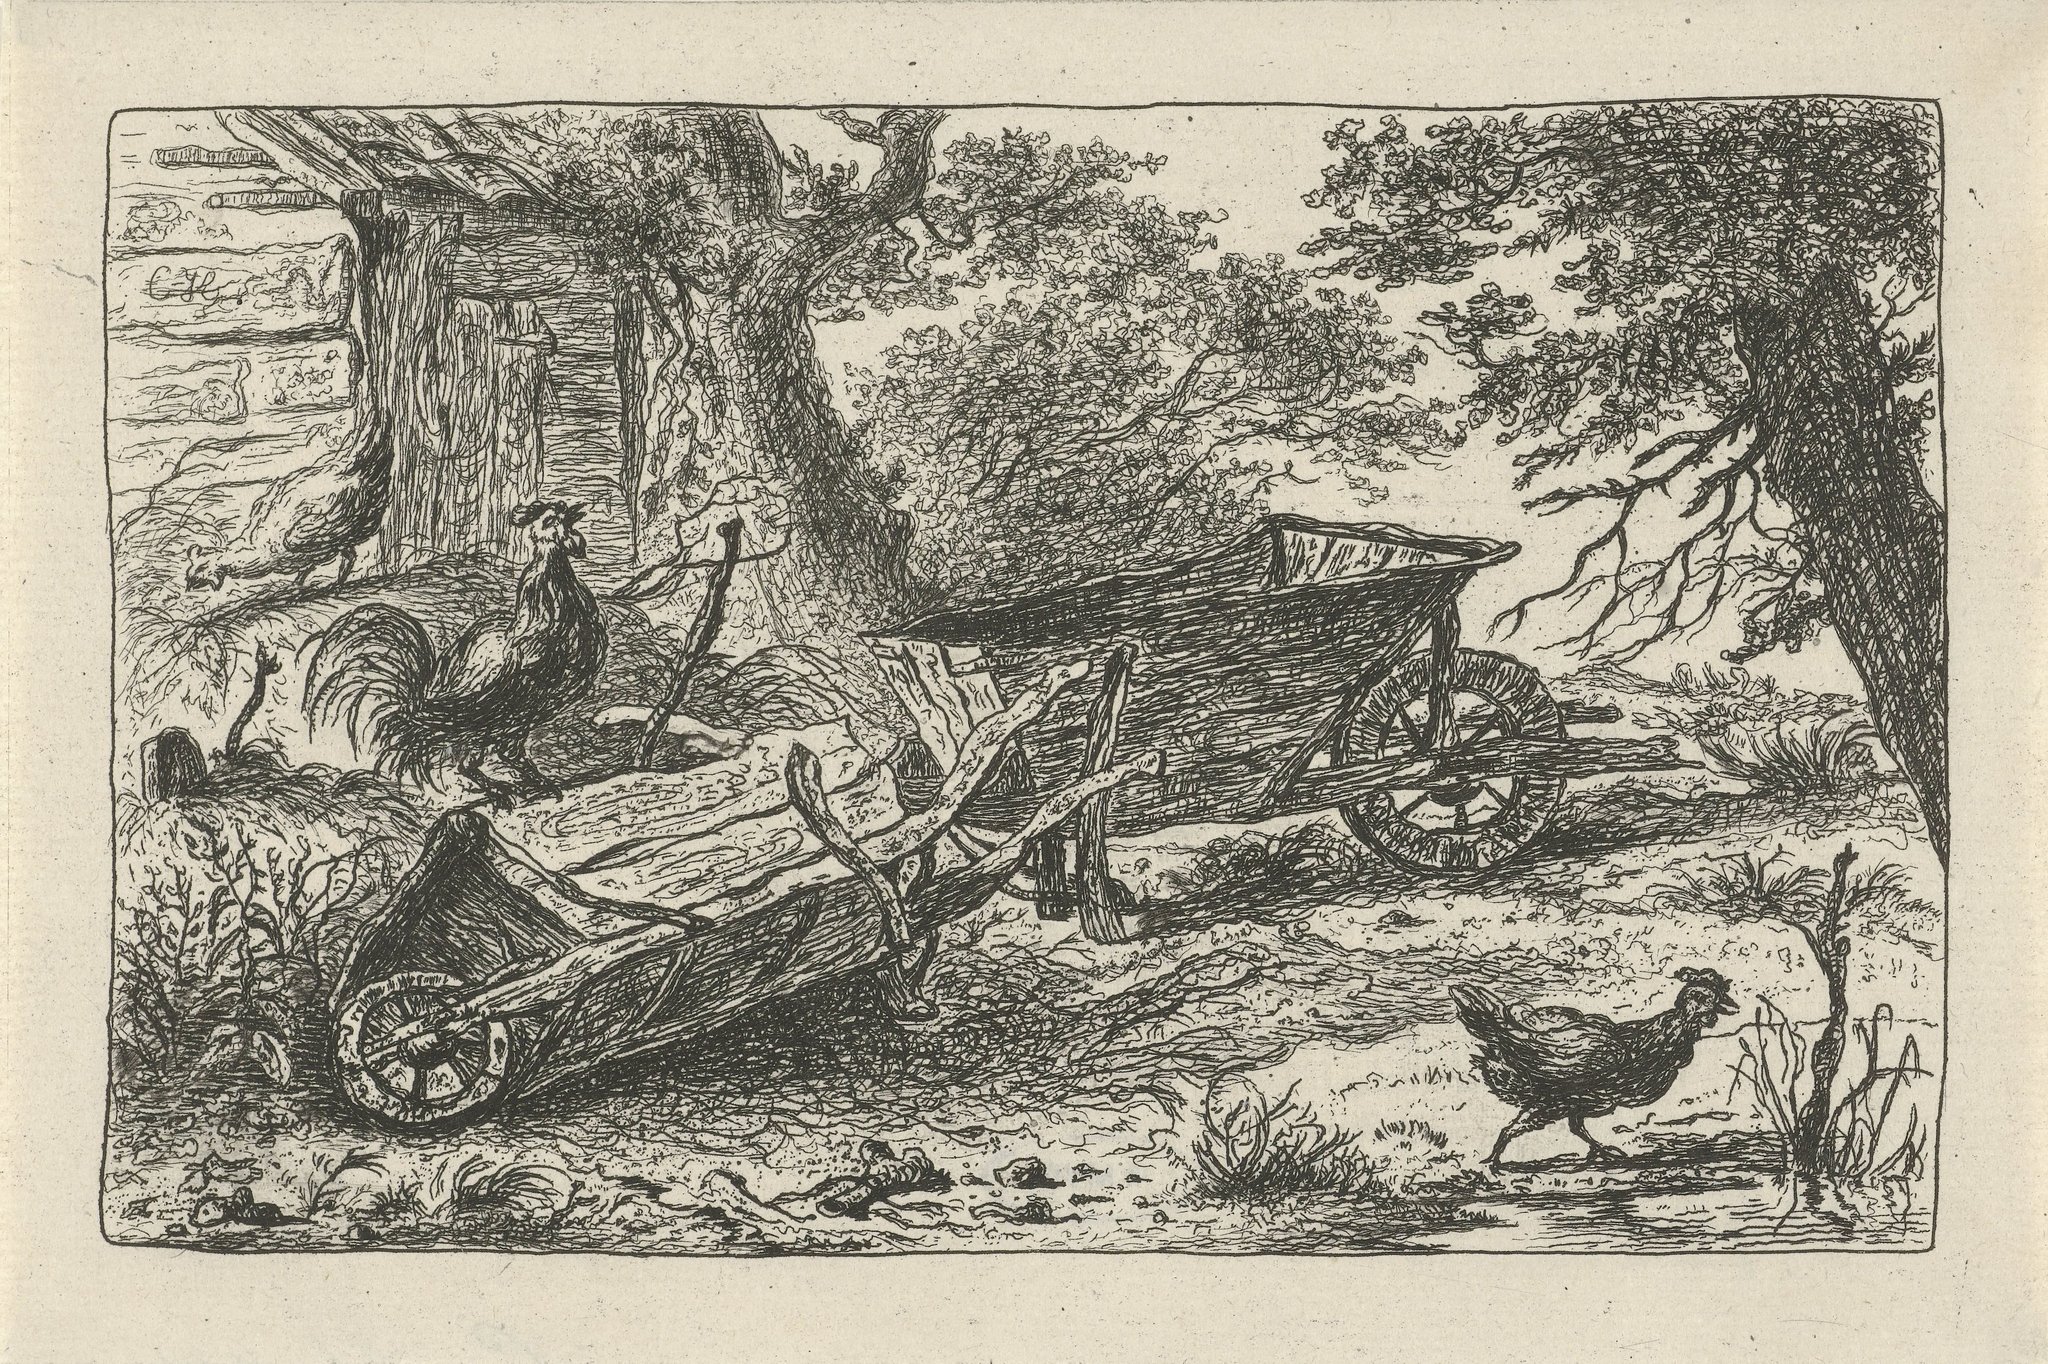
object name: print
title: Twee kruiwagens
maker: charles howard hodges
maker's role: draughtsman, painter, print maker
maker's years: 1764-1837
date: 1781-1837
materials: paper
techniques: etching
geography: netherlands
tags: wheelbarrow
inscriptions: collector's mark: Lugt 2228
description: Een gezicht op twee kruiwagens, twee kippen en een haan, bij een schuur. De haan staat op de omgevallen kruiwagen. Kopie in spiegelbeeld naar een prent van Hermanus Fock.